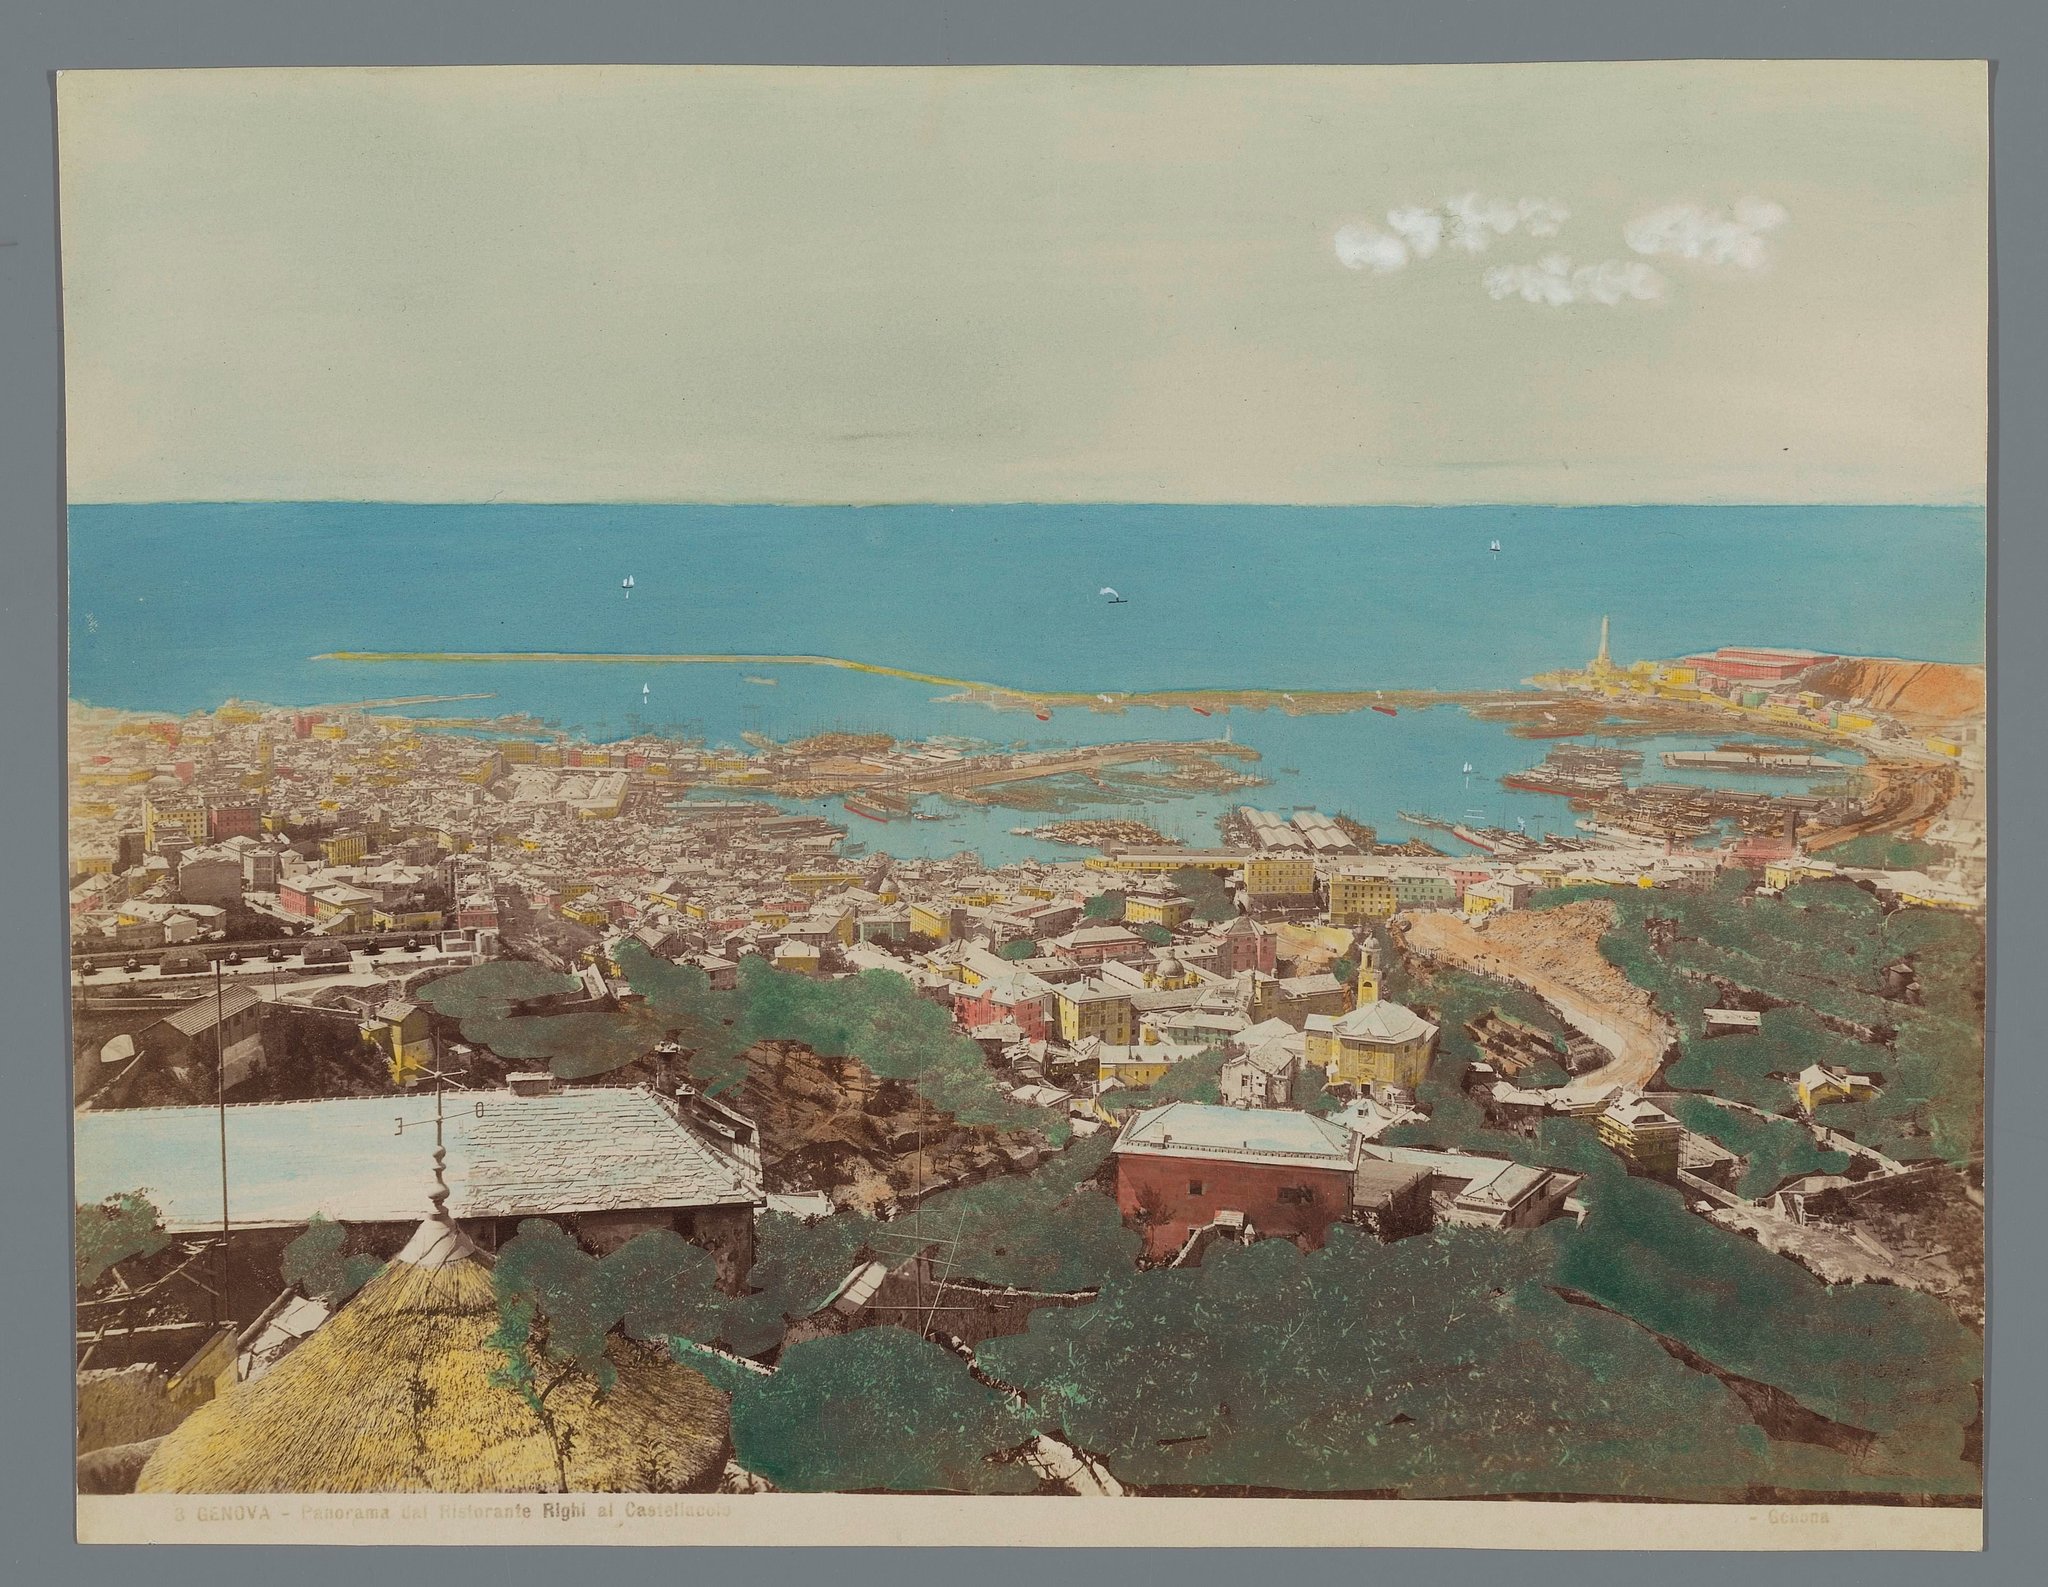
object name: photograph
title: Panorama dal Ristorante Righi al Castellaccio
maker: Anonymous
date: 1851-1900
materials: cardboard, paper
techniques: albumen print, hand coloring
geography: genoa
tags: gulf, bay, city-view in general; 'veduta'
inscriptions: number: ‘[...]3’